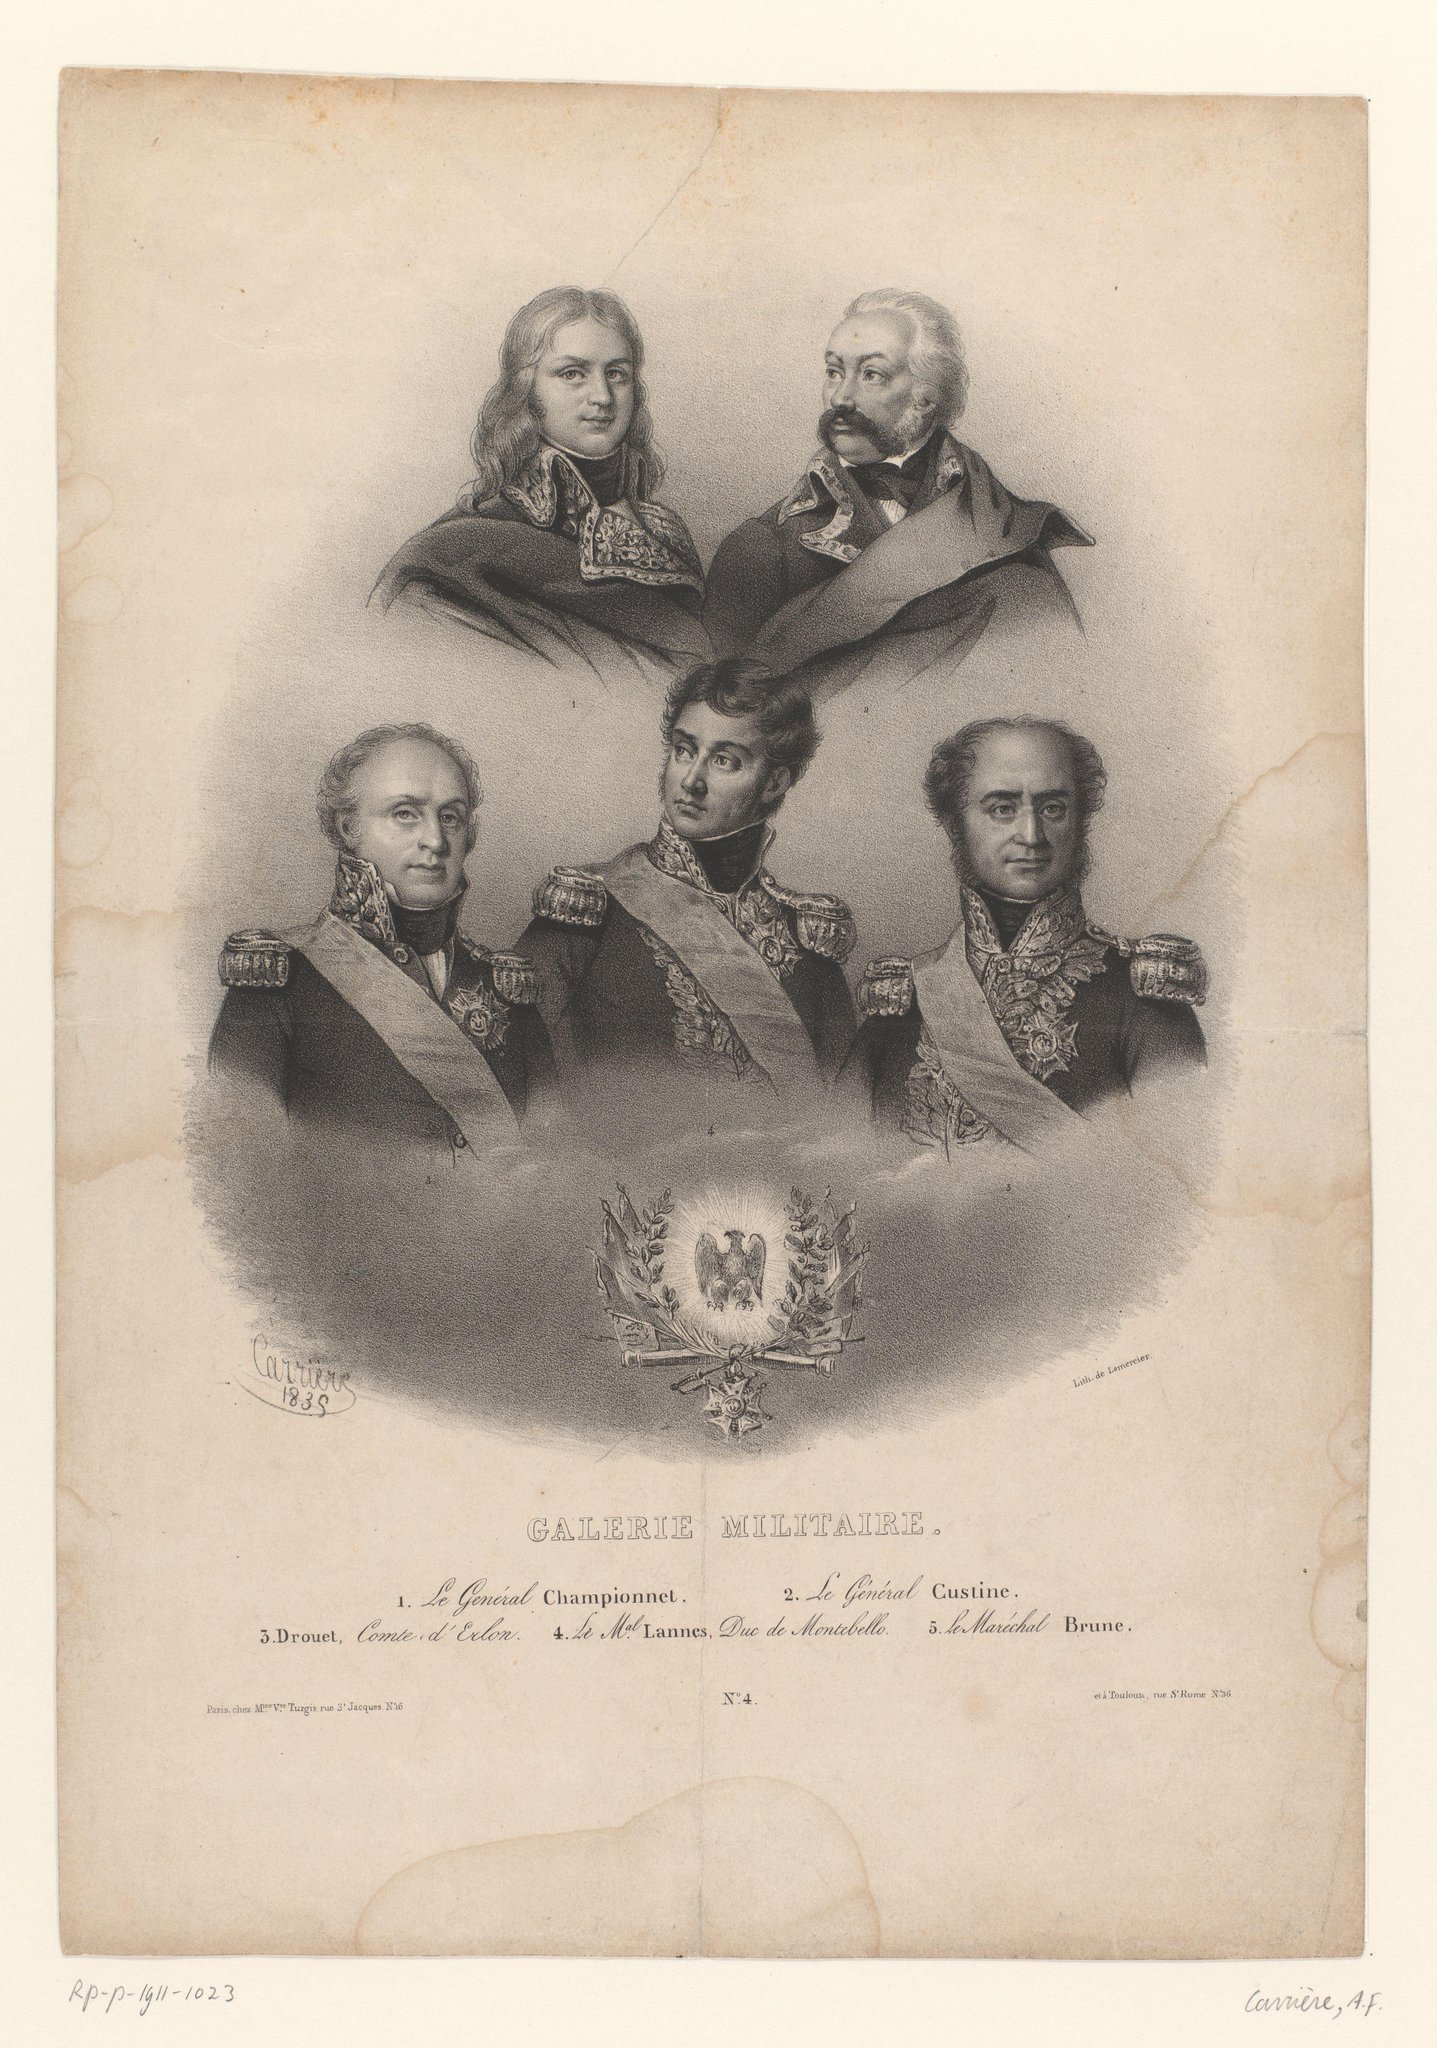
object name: print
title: Vijf portretten van maarschalken en generaals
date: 1835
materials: paper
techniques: lithograph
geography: paris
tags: paris, historical persons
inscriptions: collector's mark: Lugt 2228a